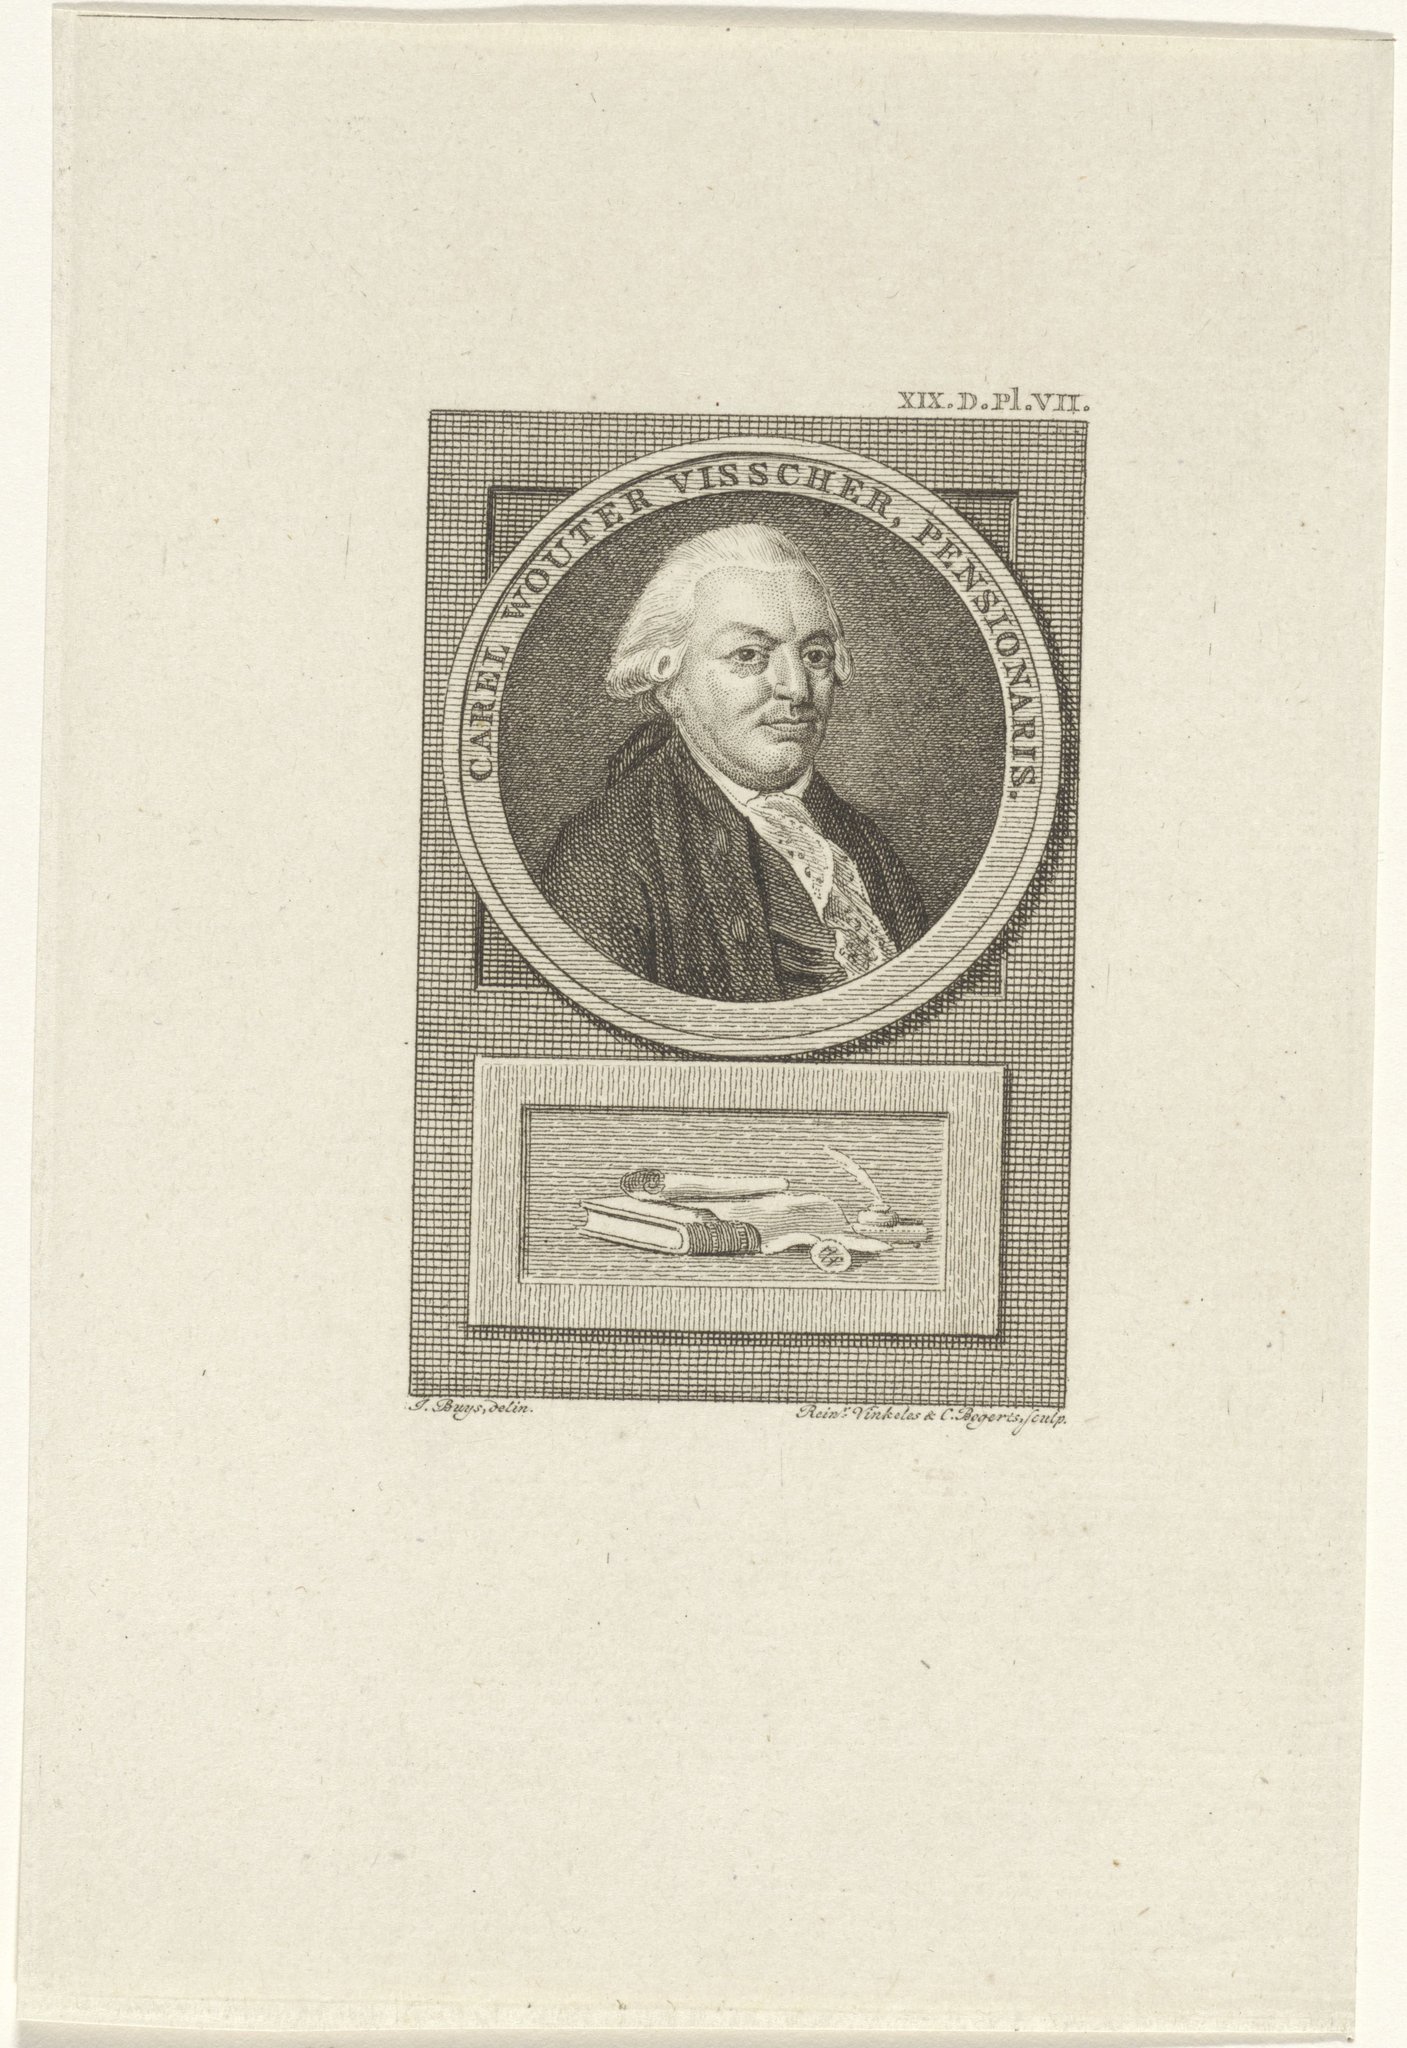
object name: print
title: Portret van Carel Wouter Visscher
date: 1783-1795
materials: paper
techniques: engraving, etching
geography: amsterdam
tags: quill, ink-well, seal, stamp, book, paper (writing material)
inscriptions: collector's mark: Lugt 2228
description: Prent gebruikt in: Fokke, Jan. Geschiedenissen der Vereenigde Nederlanden voor de vaderlandsche jeugd Ie-XXVste deel. Amsterdam: Johannes Allart, 1783-1795. Deel XIX.